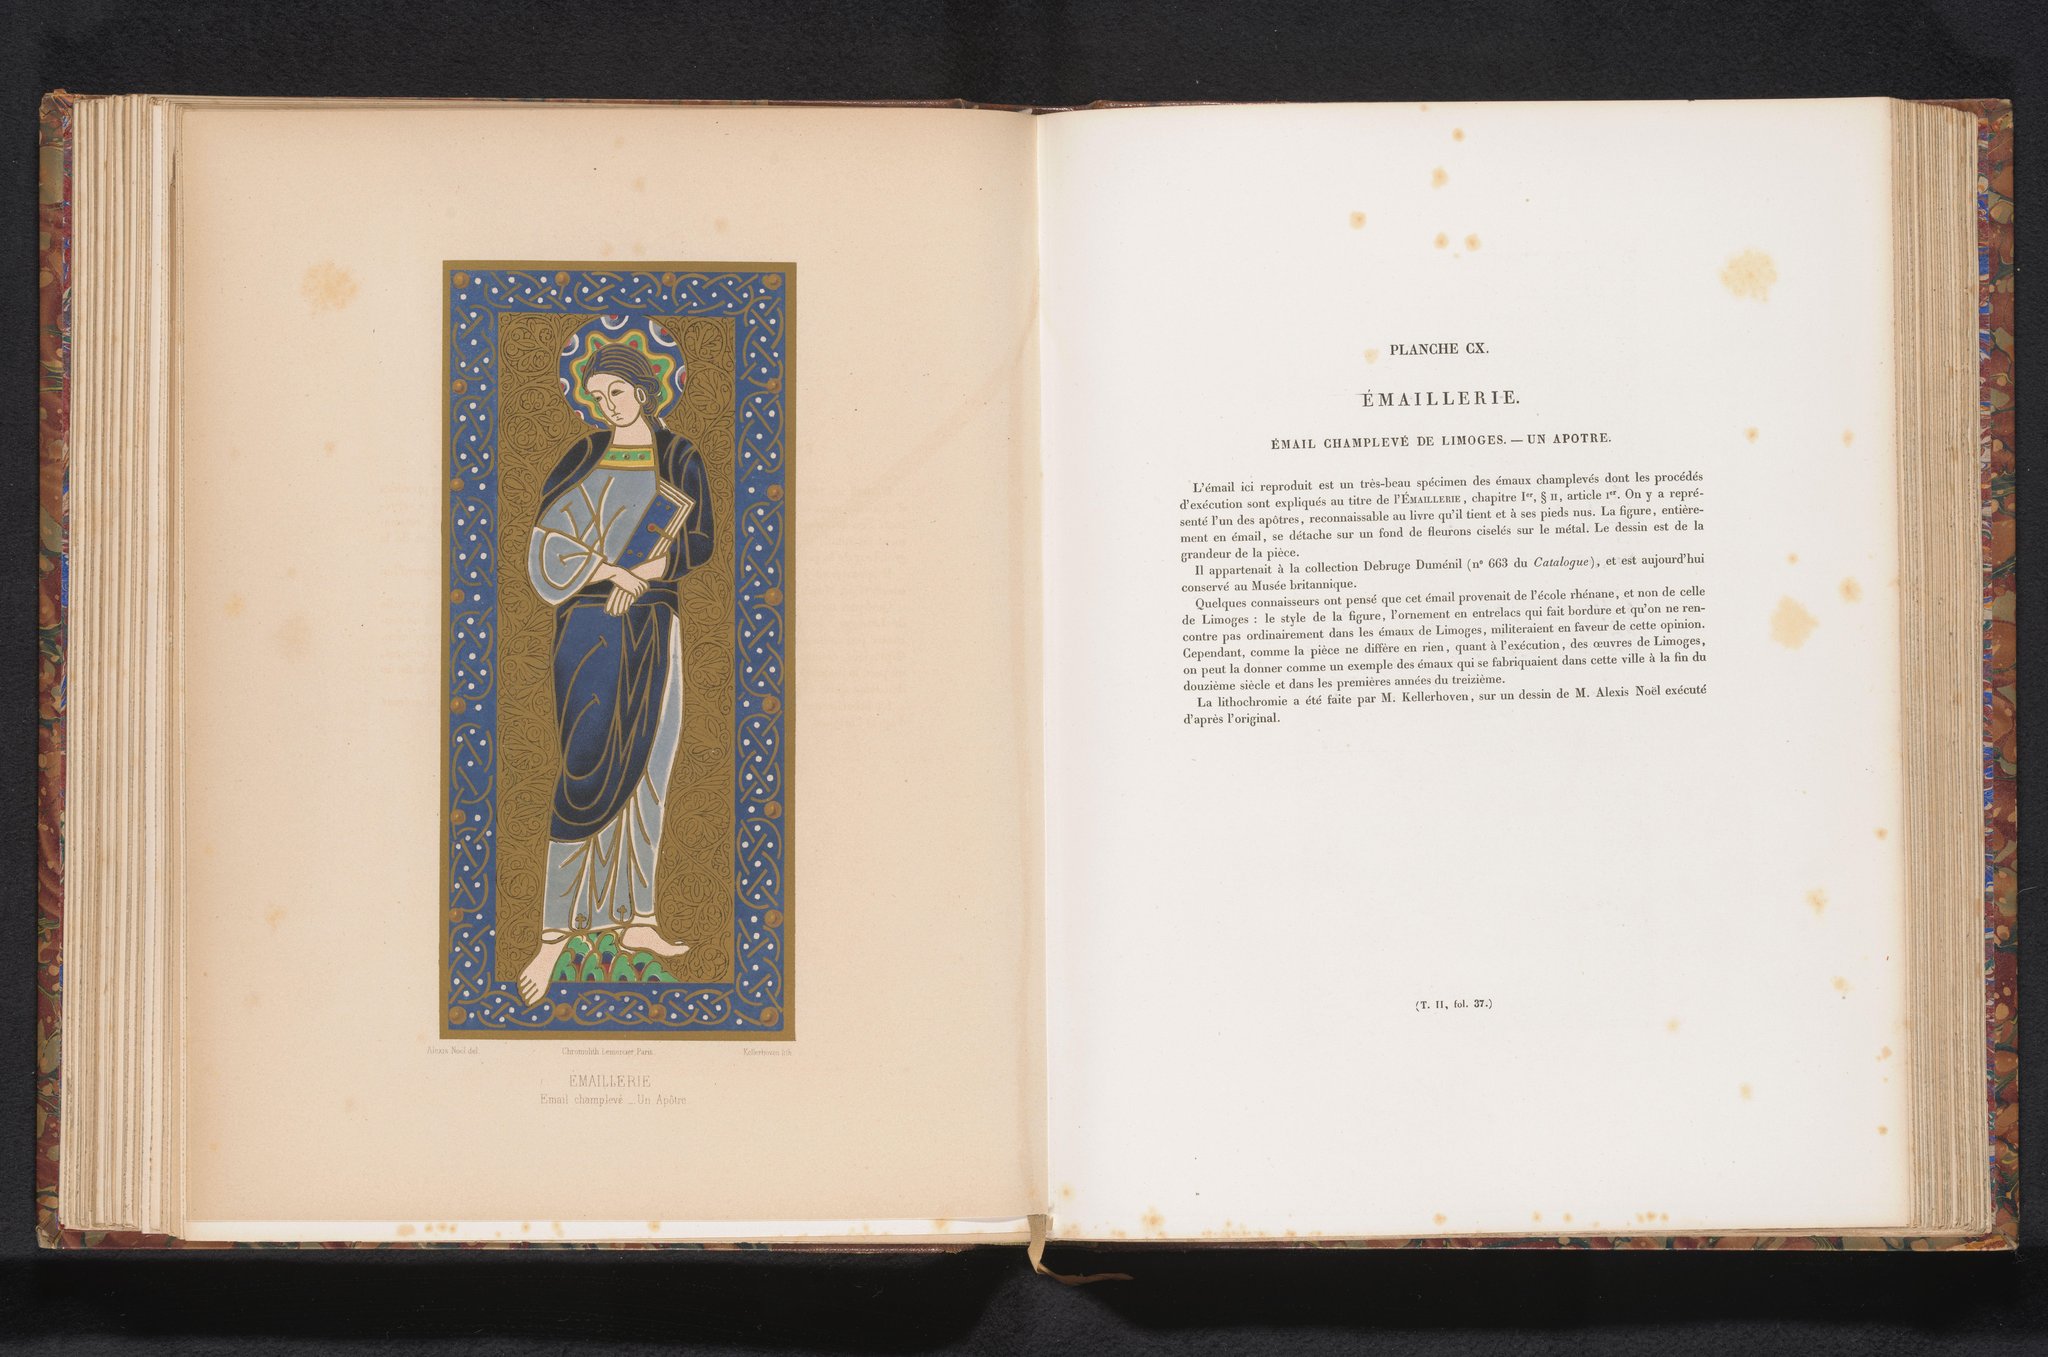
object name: page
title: Email champlevé, Un Apôtre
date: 1859-1864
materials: paper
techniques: chromolithography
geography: paris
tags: (single) apostle, unspecified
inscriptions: name: ‘Alexis Noël del./ Kellerhoven lith.’